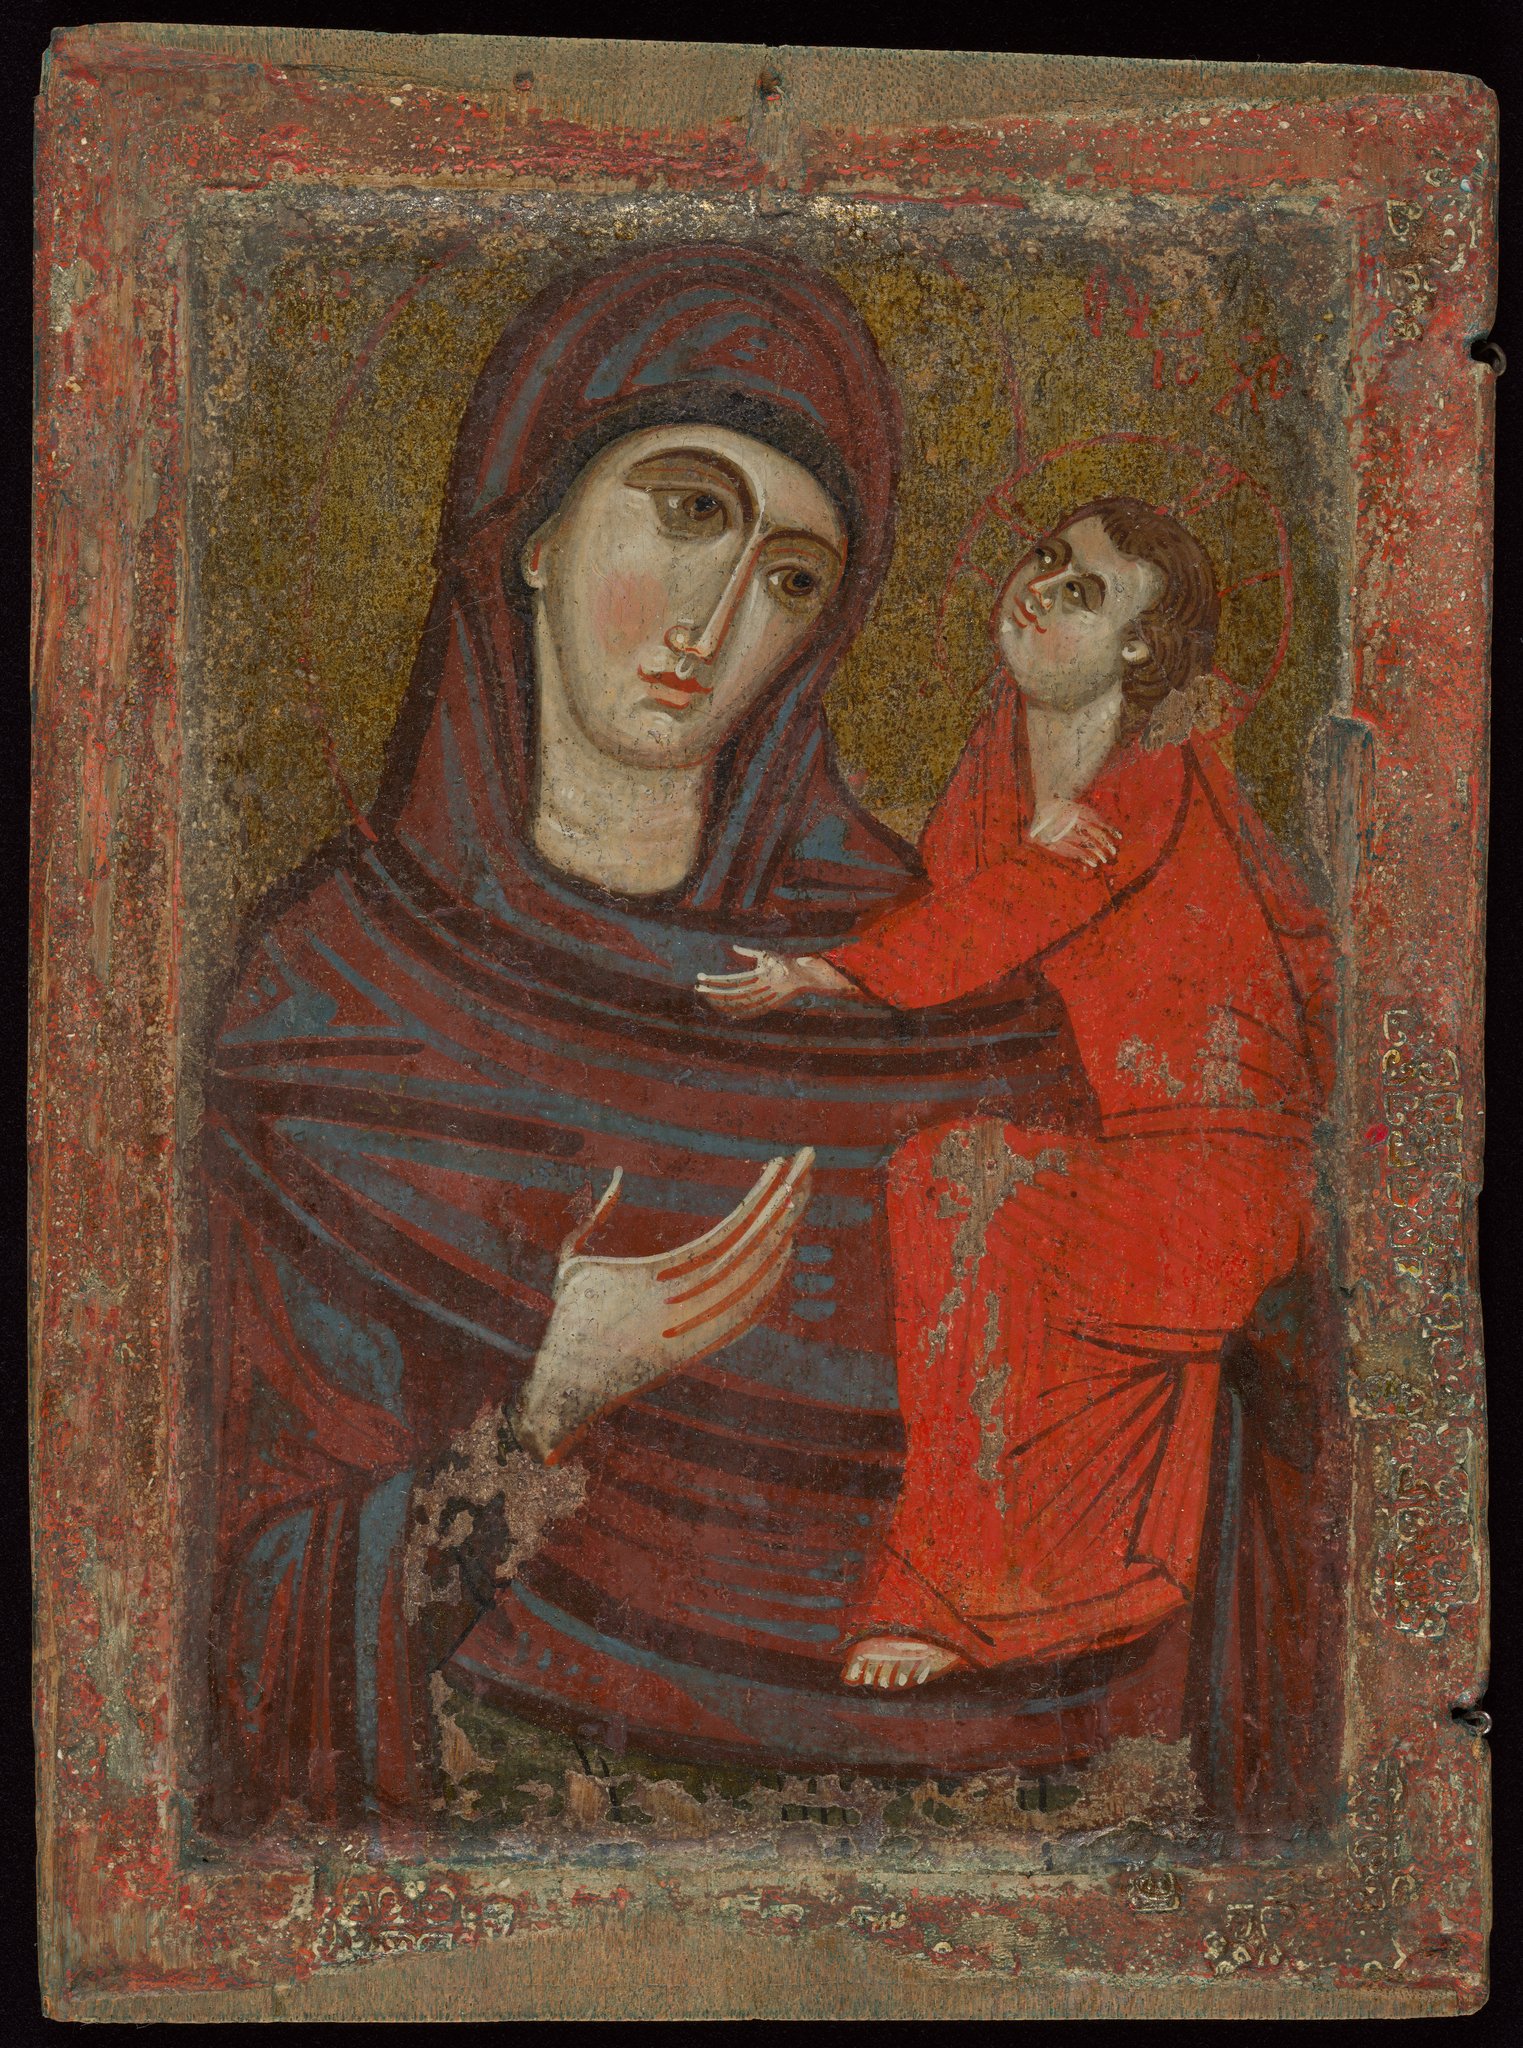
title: Icon of the Virgin and Child, Hodegetria variant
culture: byzantine or crusader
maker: byzantine or crusader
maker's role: artist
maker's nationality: byzantine or crusader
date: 1201-1300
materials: paint, wood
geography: egypt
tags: madonna and child